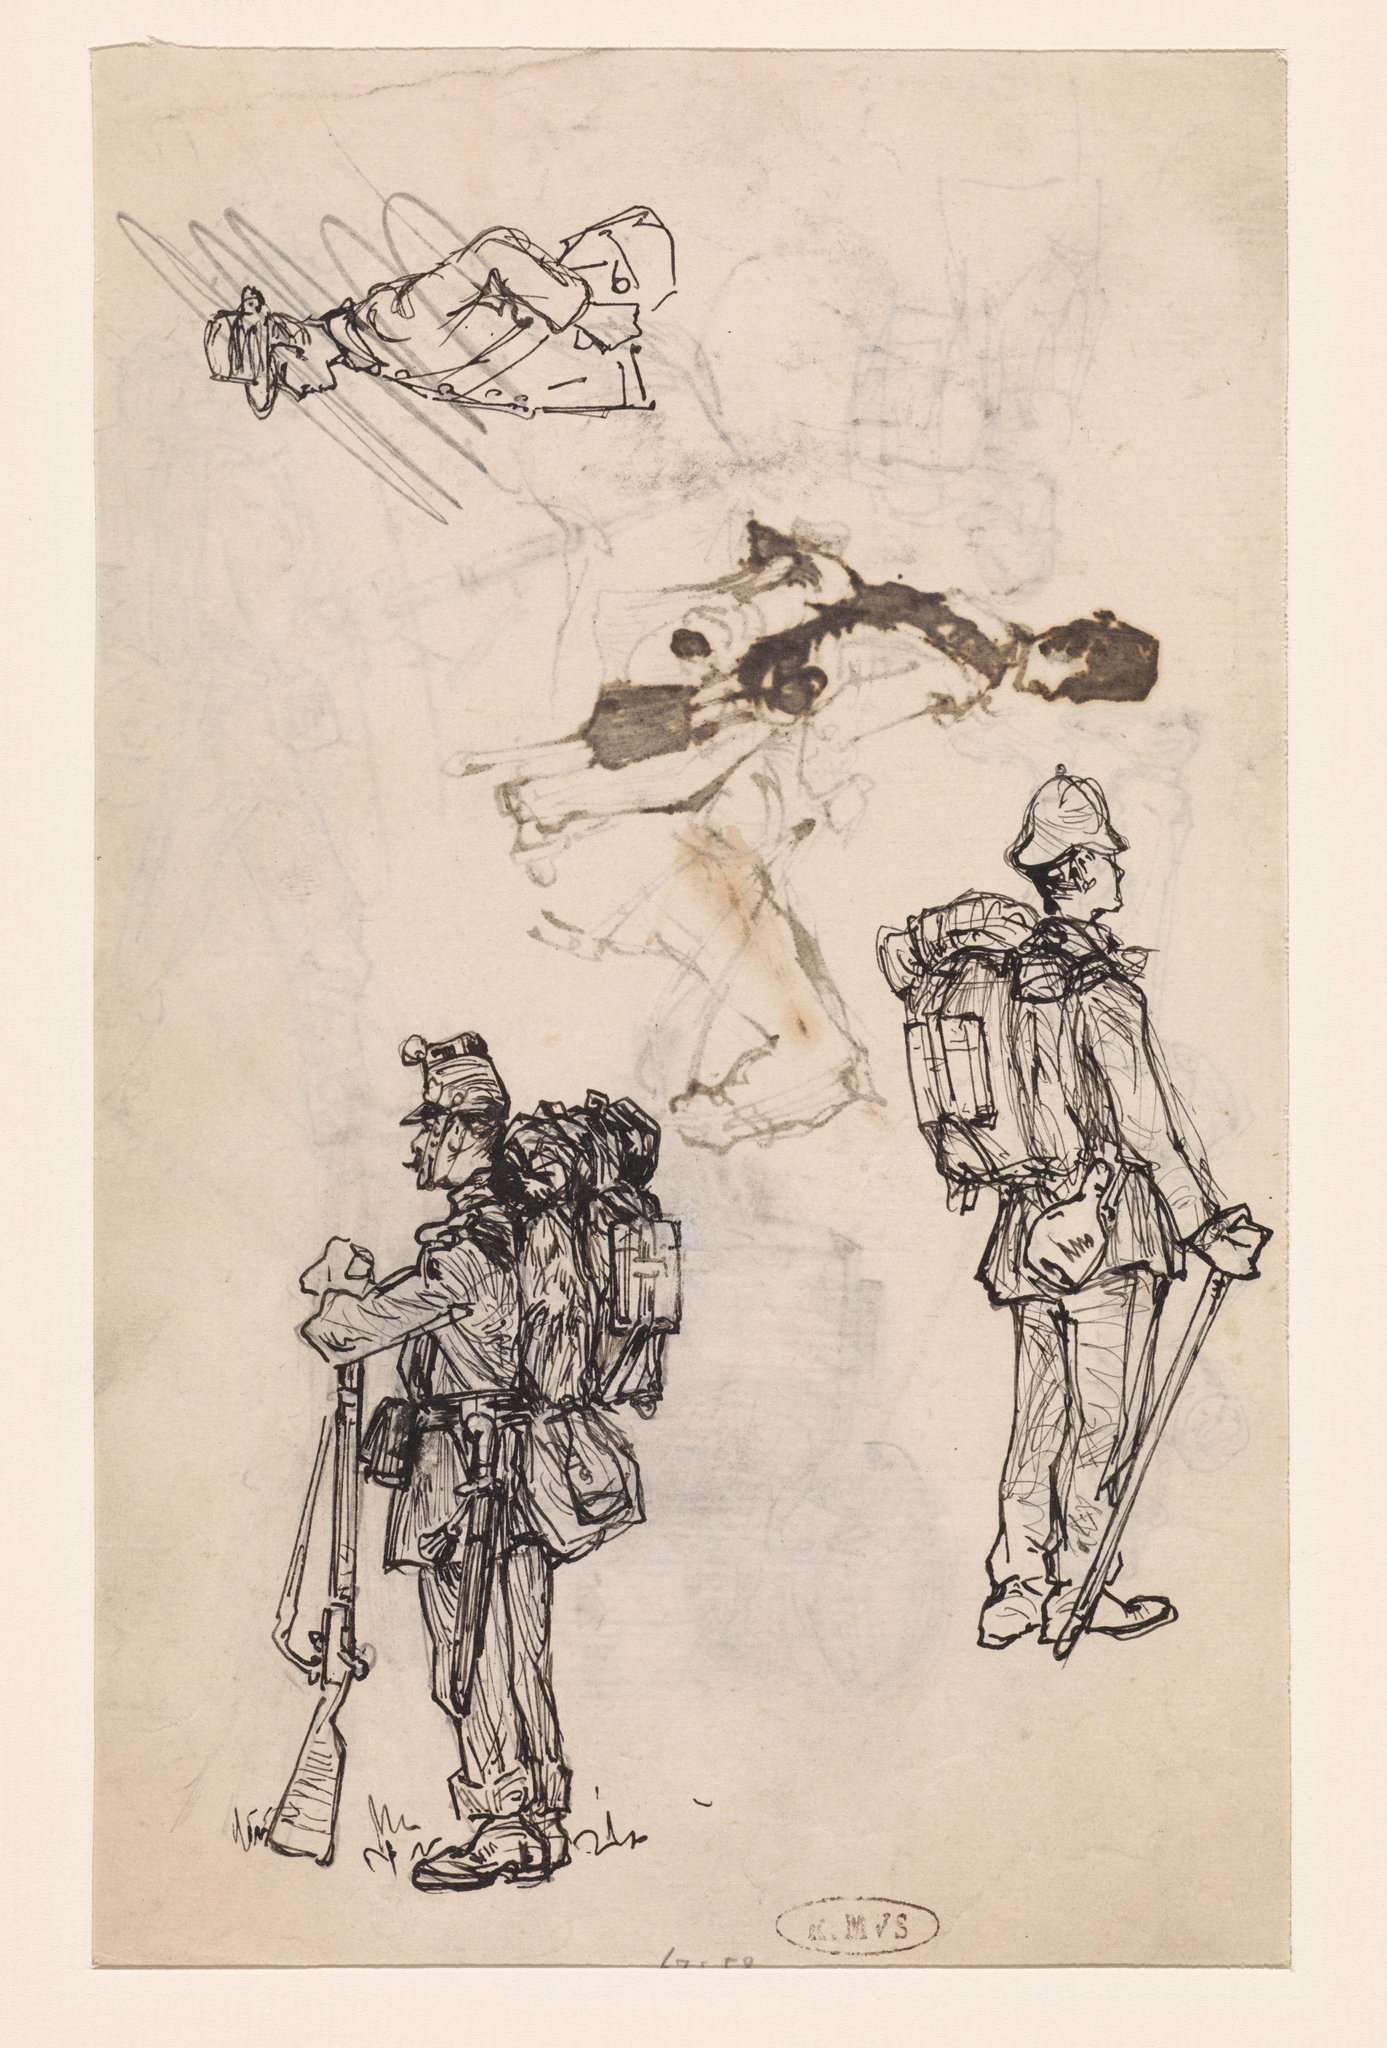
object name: drawing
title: Studies van huzaren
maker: edzard koning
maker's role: draughtsman, print maker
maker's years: 1869-1954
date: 1879-1954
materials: ink, paper, pencil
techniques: pen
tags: private soldier